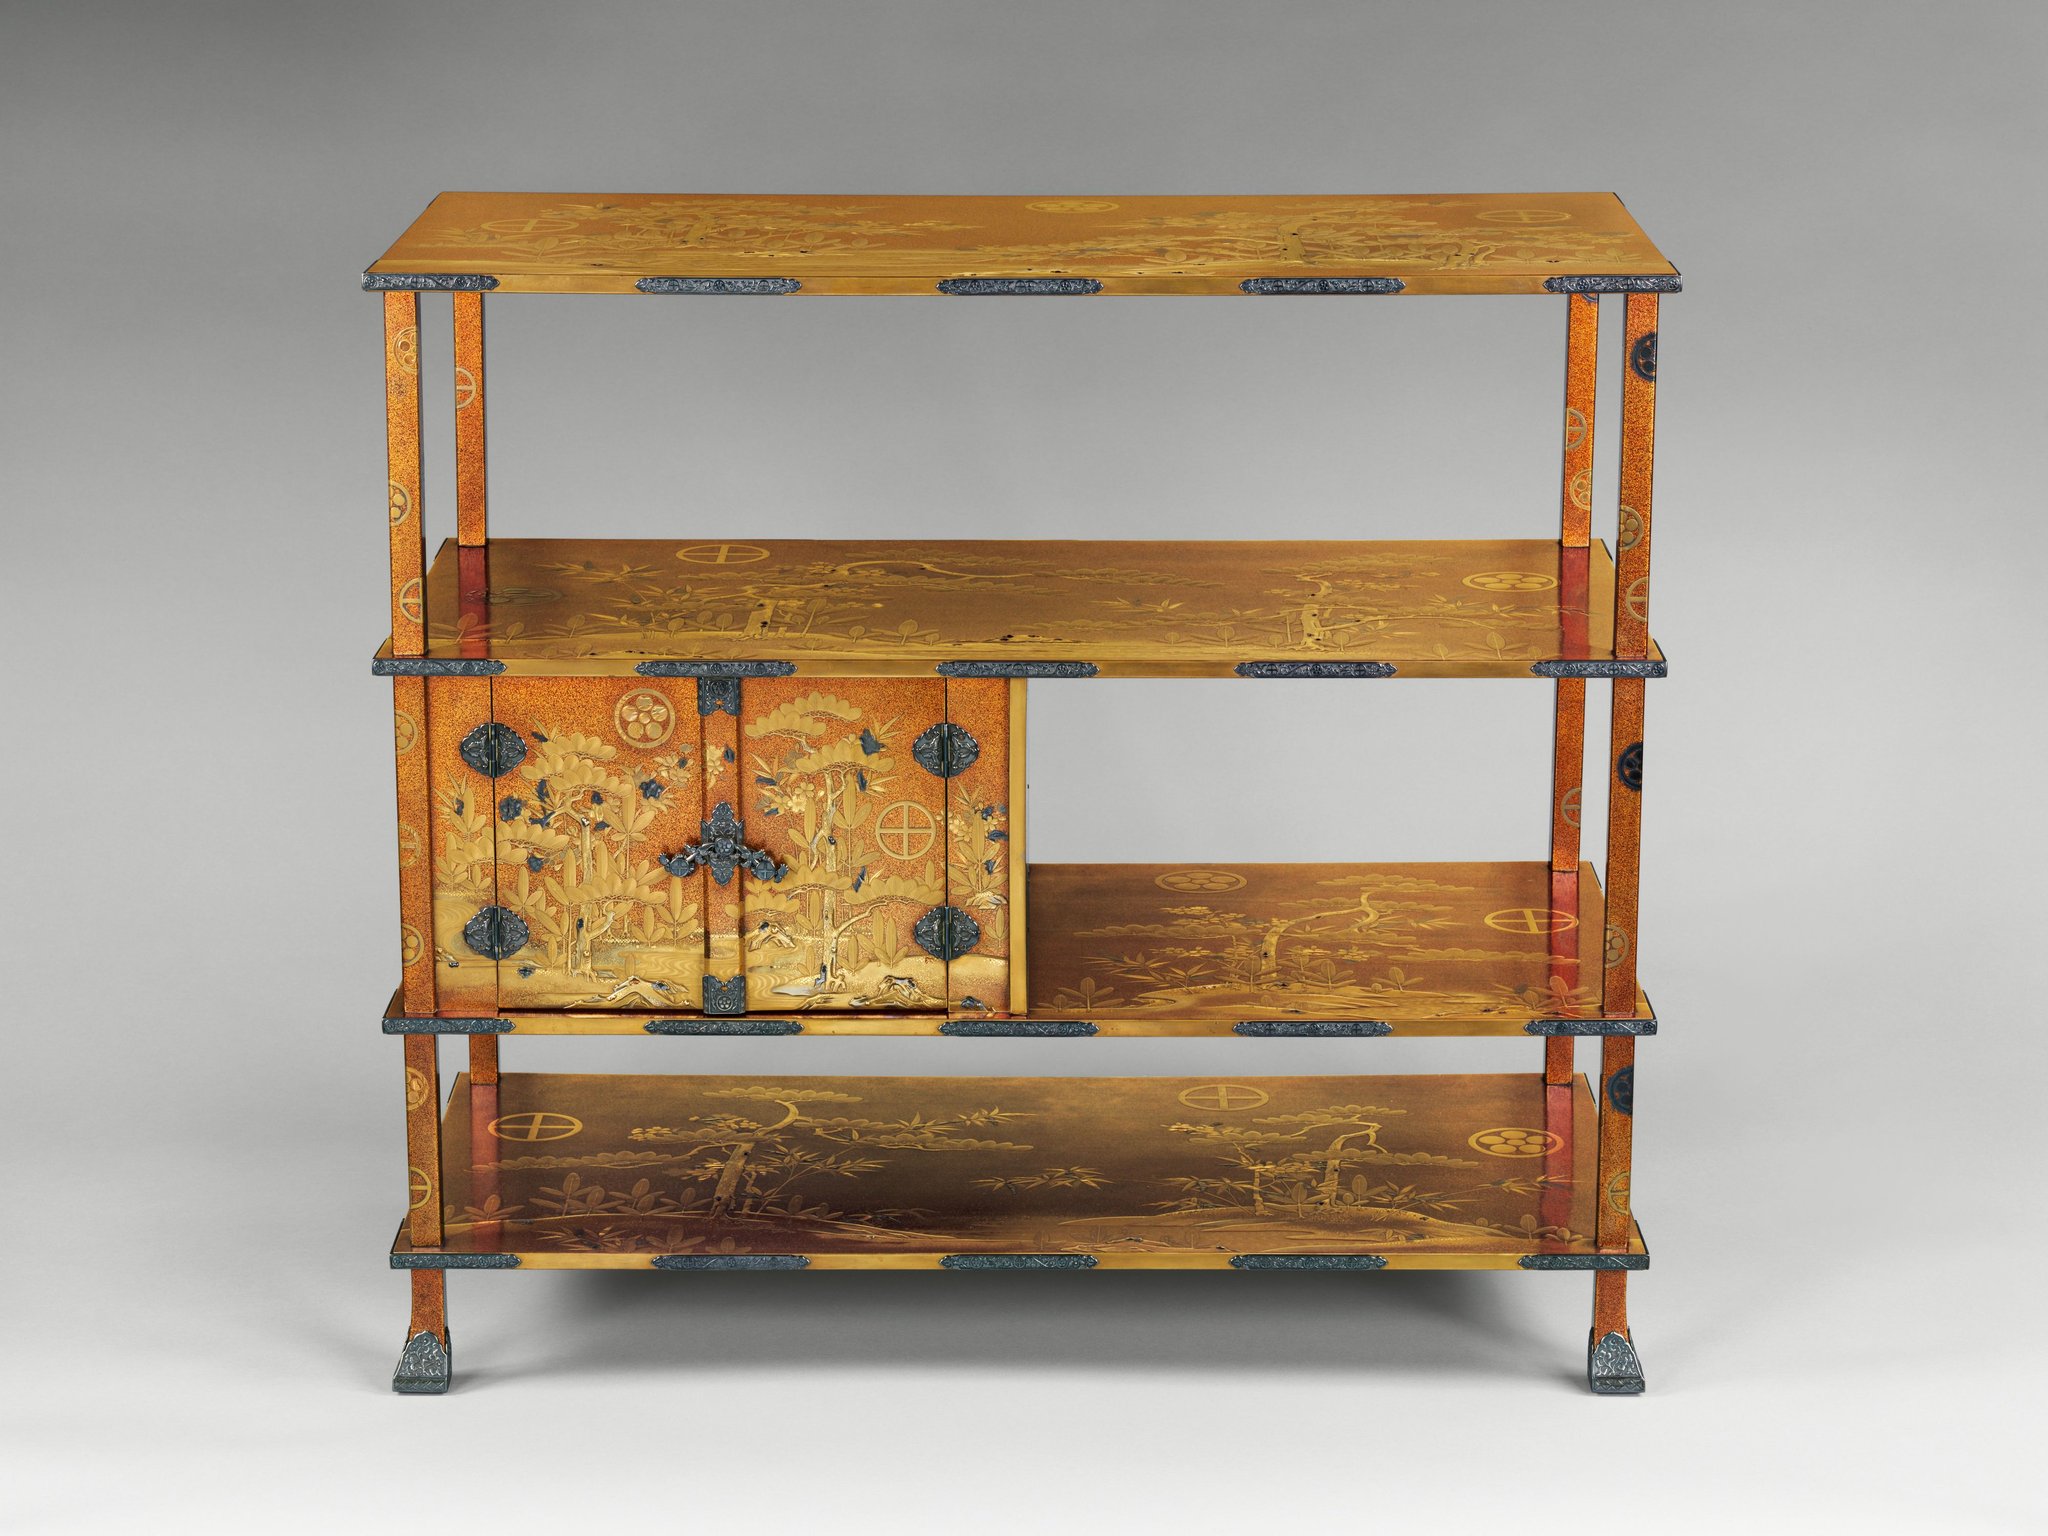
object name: cosmetic shelf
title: Shelf for Cosmetic Boxes (Kuro-dana) with Pine, Bamboo, Cherry Blossoms, and Crests of the Matsudaira and Shimazu Families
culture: japanese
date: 1801-1833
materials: foil, gold, silver, wood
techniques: hiramakie, lacquer, maki-e